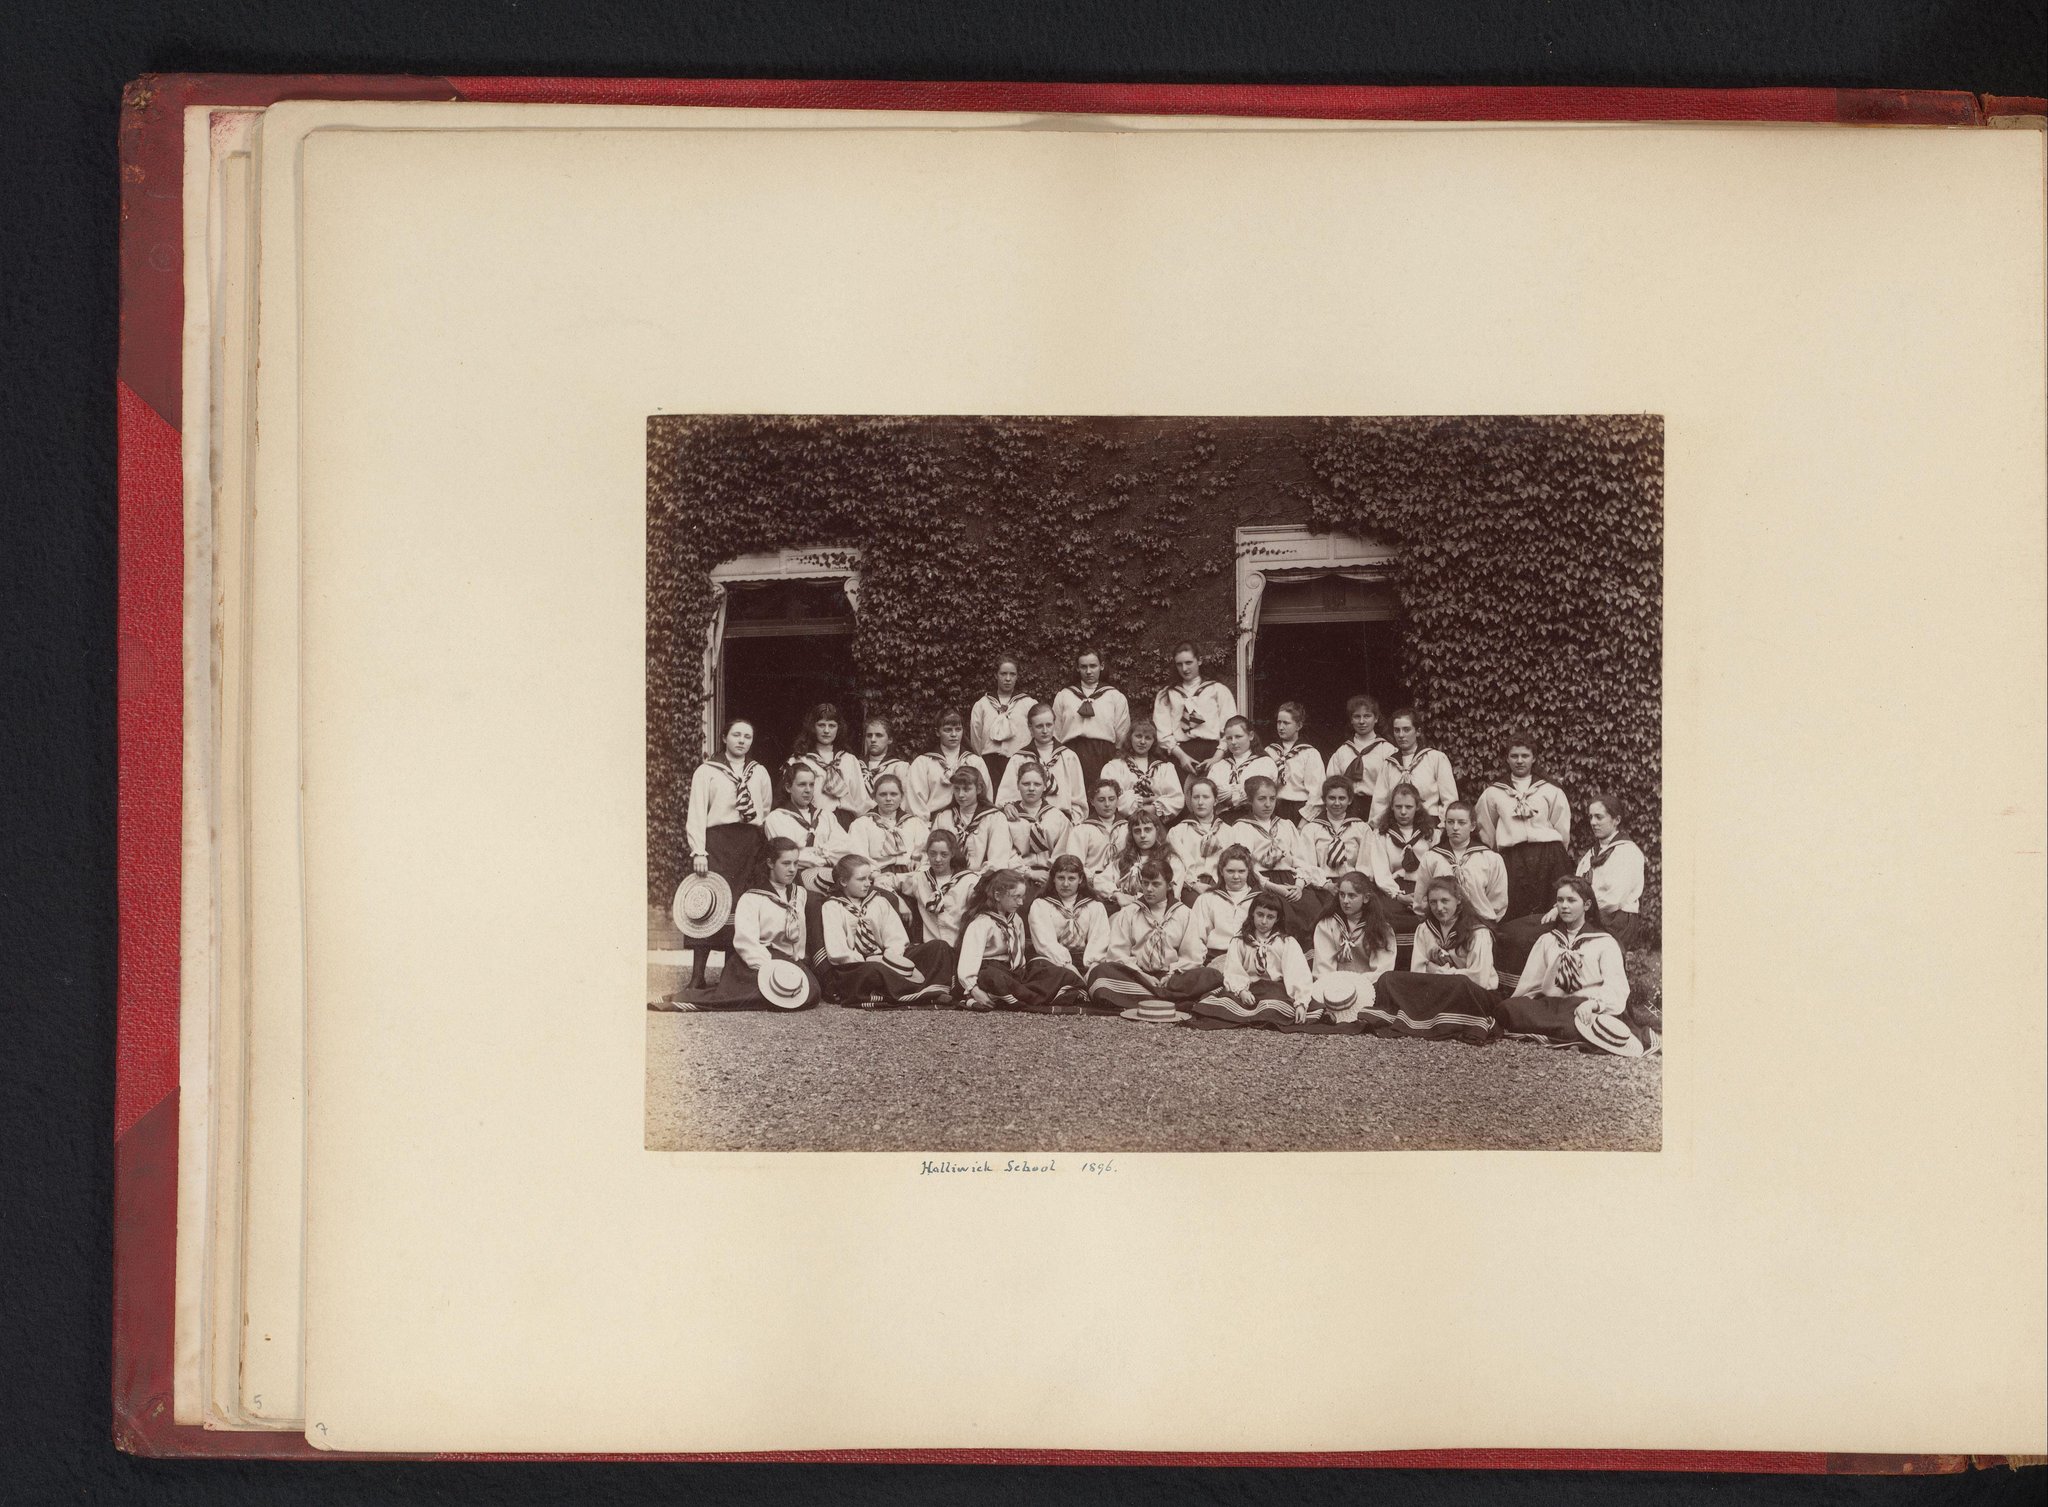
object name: photograph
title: Groepsportret met leerlingen van de Halliwick School for Girls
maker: Anonymous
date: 1896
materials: cardboard, photographic support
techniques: albumen print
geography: london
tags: anonymous historical persons portrayed in a group, in a group-portrait - bb - woman, student - bb - female student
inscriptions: annotation: ‘Halliwick School. 1896.’